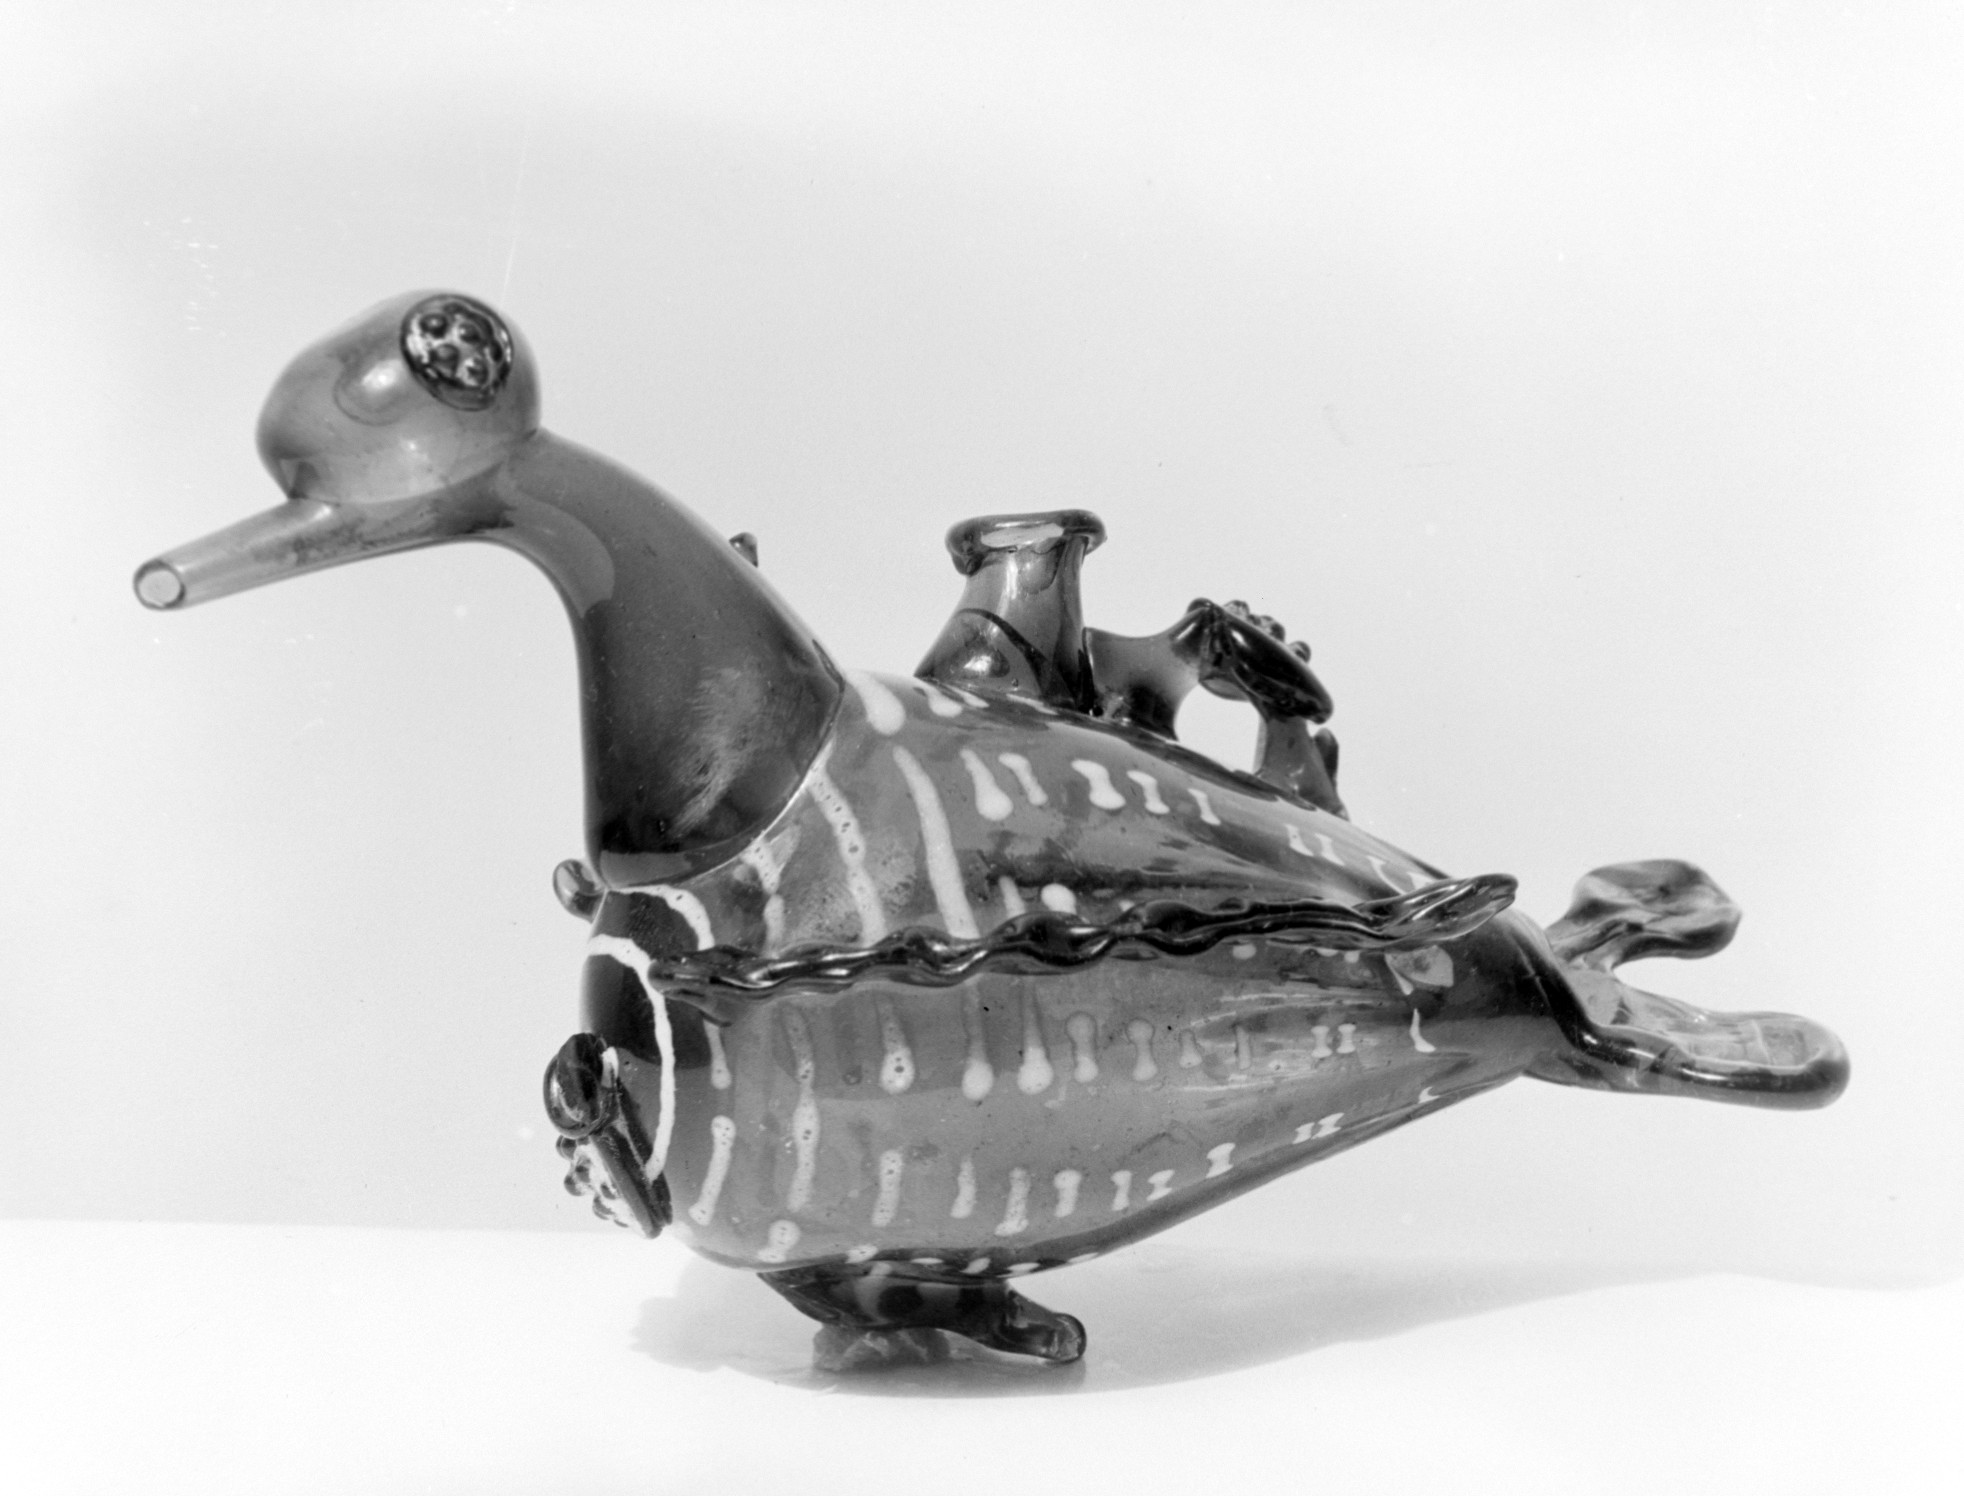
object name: bottle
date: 1701-1800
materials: glass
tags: birds